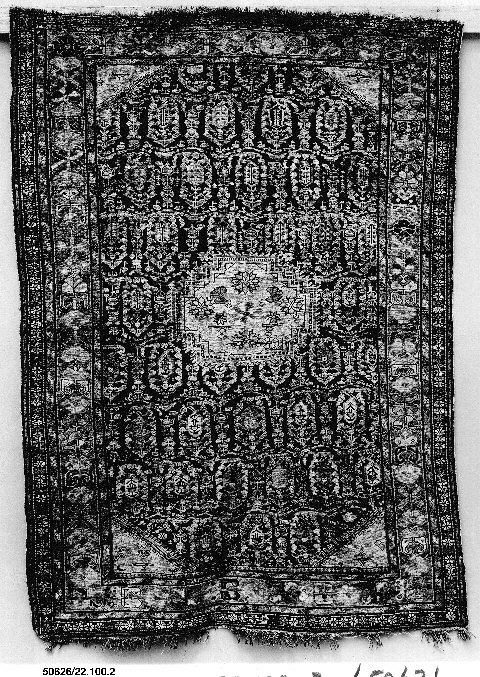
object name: carpet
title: So-called "Chila"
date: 1801-1900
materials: wool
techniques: pile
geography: azerbaijan